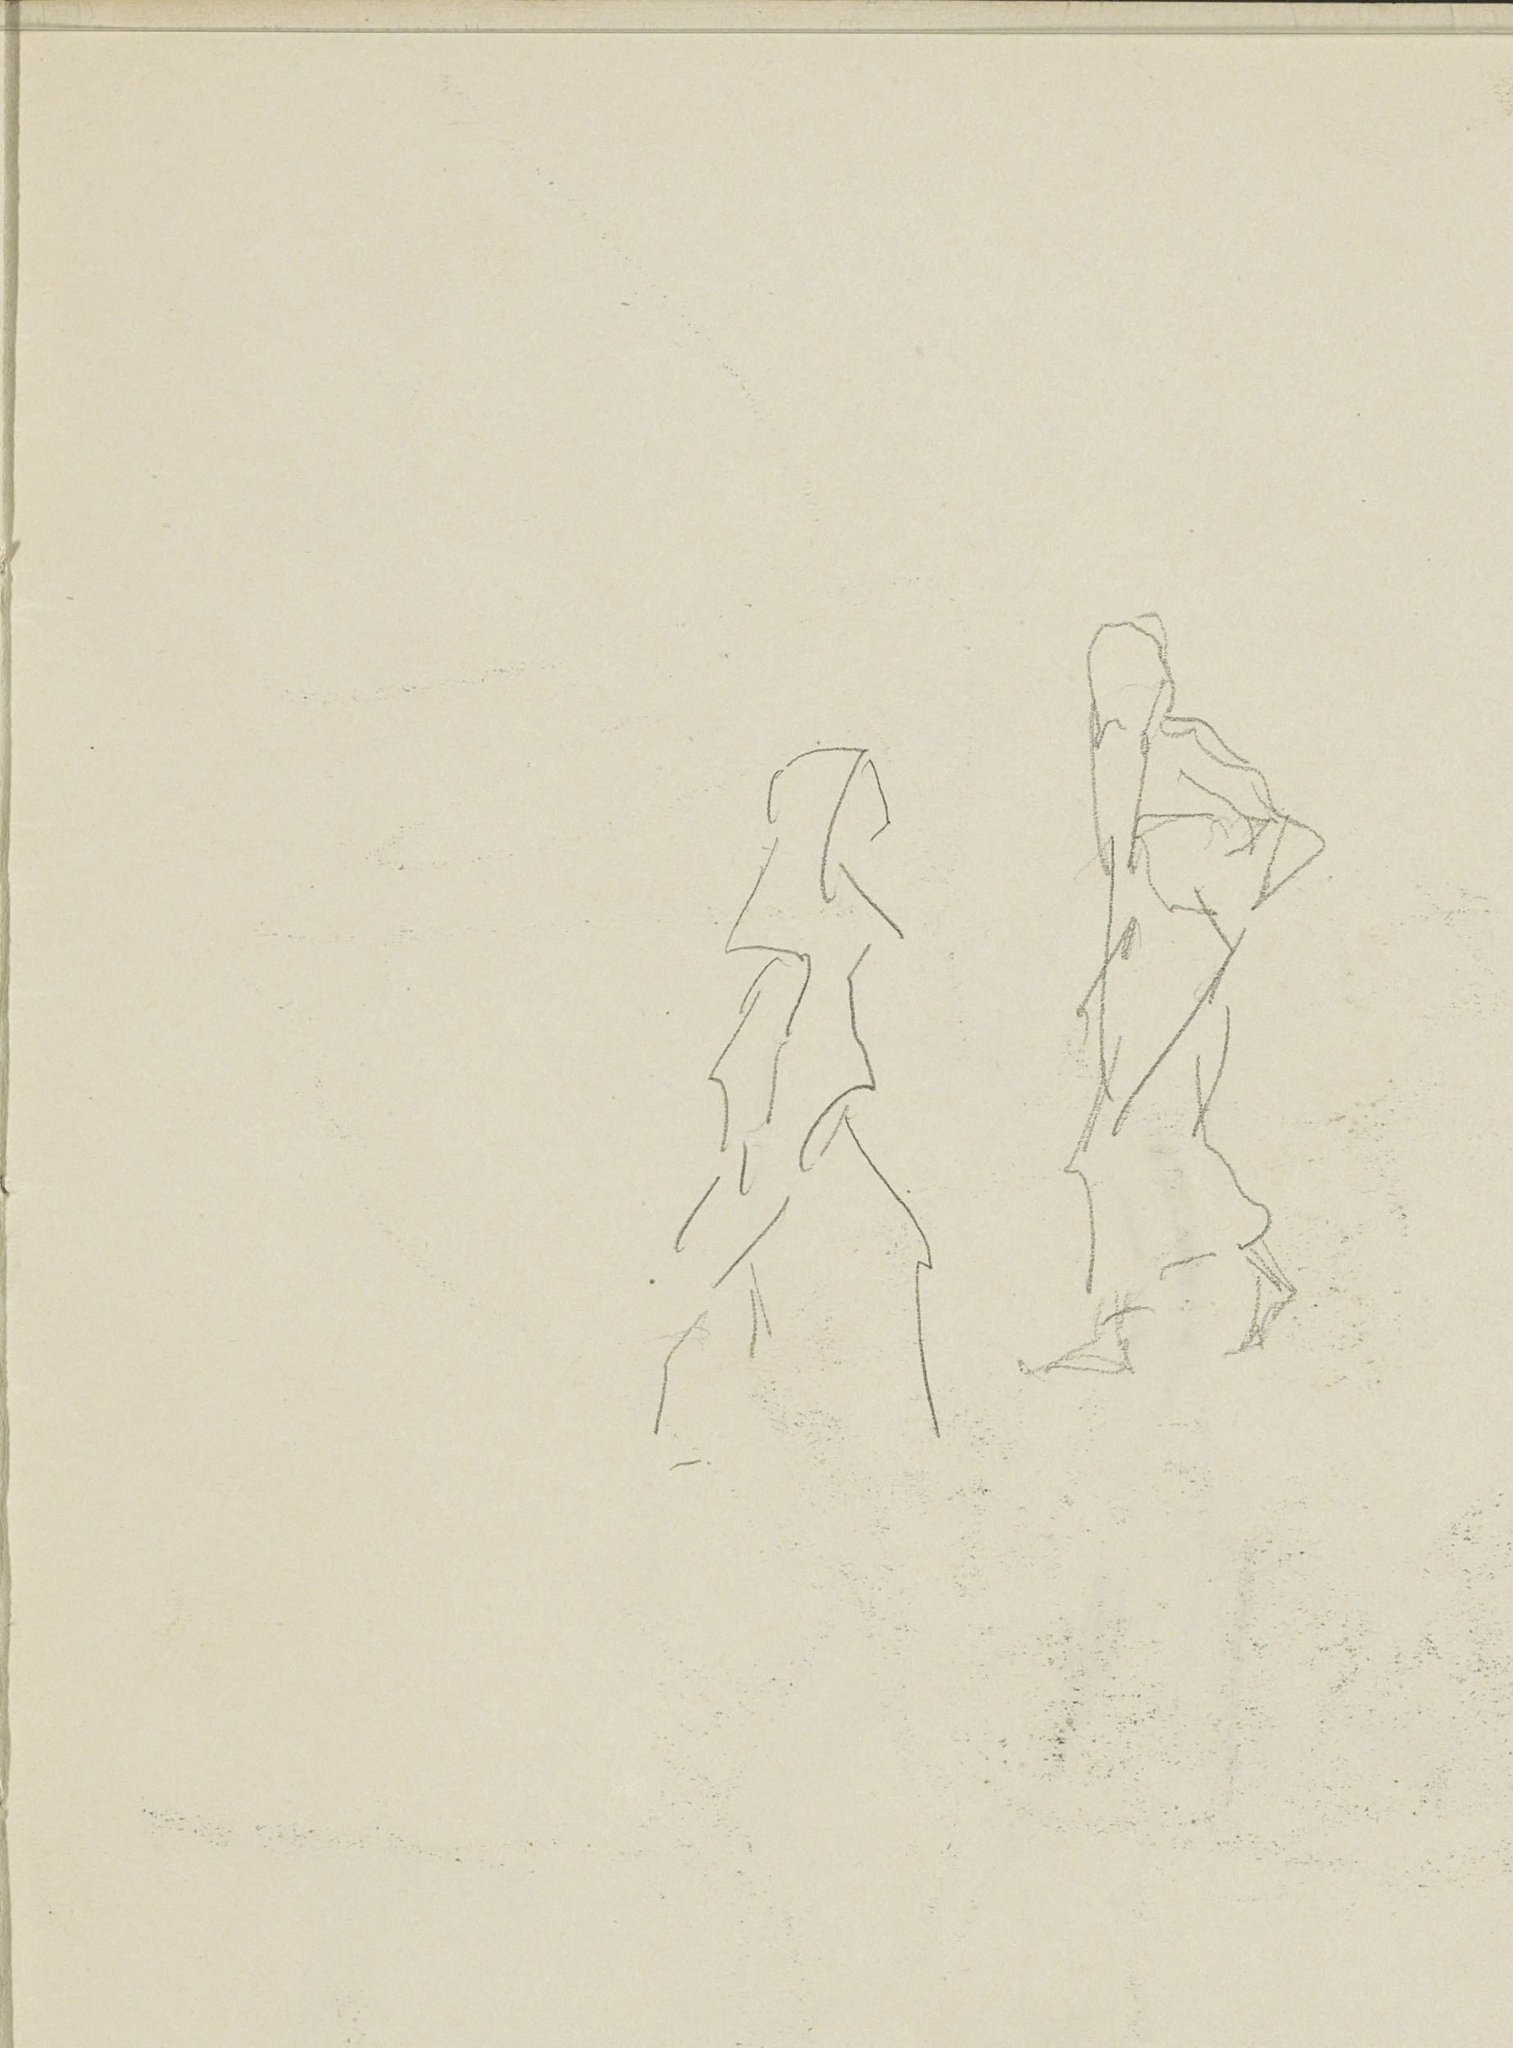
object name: sketchbook leaf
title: Twee figuren in gewaden, in profiel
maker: isaac israels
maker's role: draughtsman, painter, print maker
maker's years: 1865-1934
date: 1875-1934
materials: paper, pencil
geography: the hague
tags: adult woman (+ standing), adult man (+ standing)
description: Blad 7 recto uit schetsboek XXIV met 10 bladen.